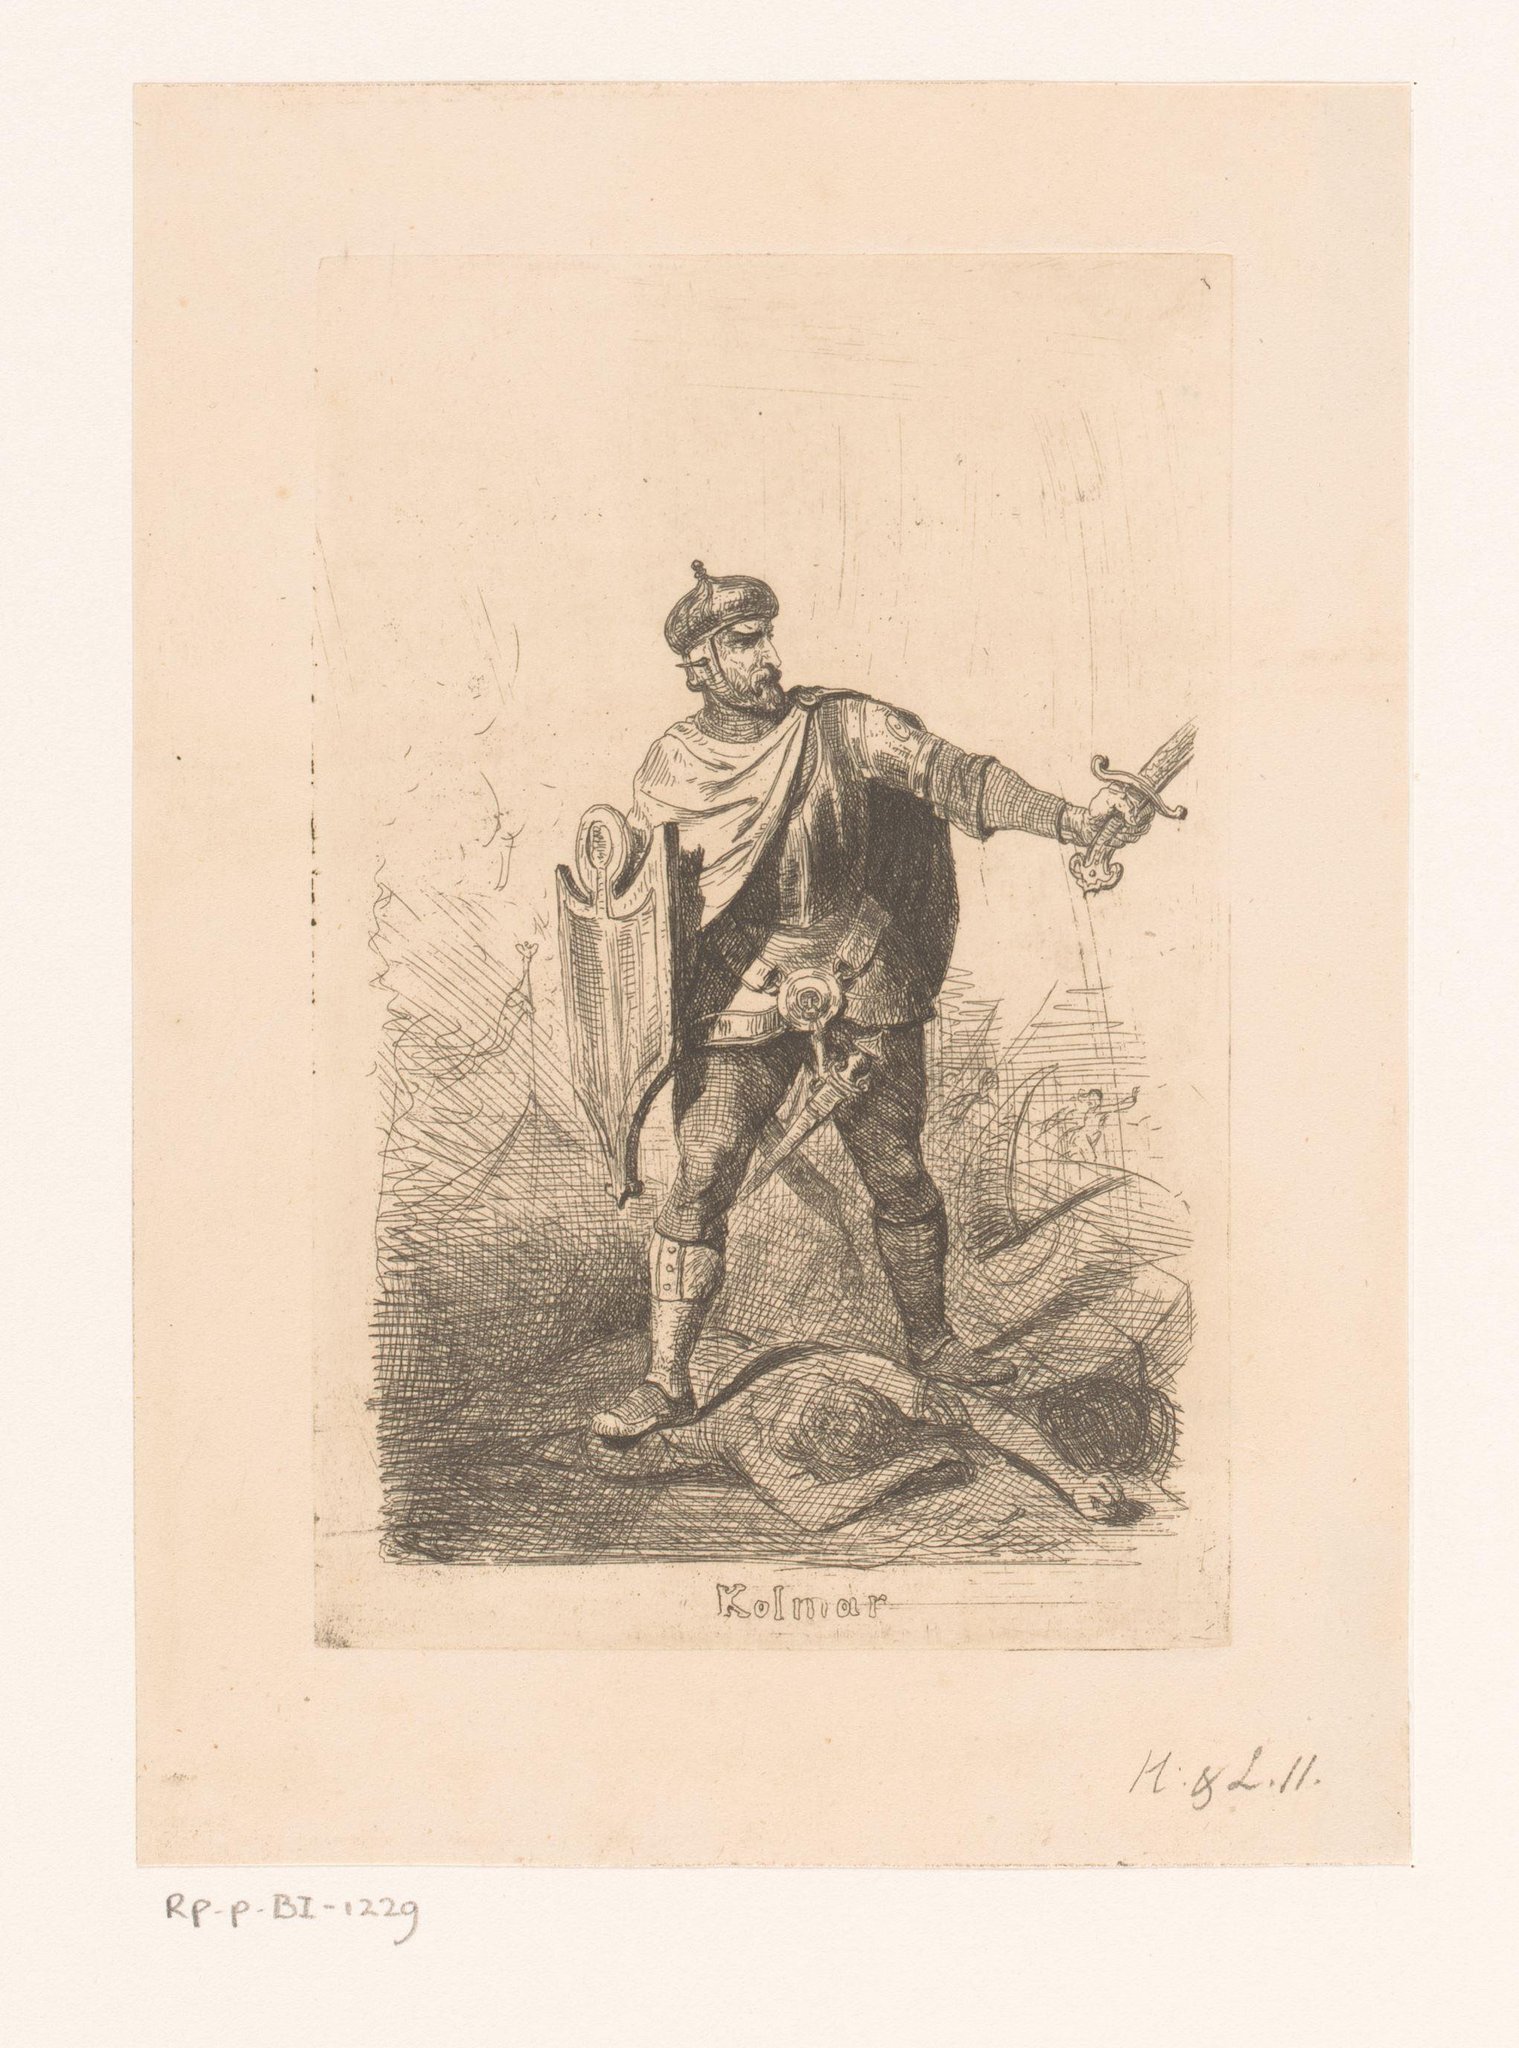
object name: print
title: Kolmar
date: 1842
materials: paper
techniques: etching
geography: antwerp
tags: armour, adult man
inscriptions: collector's mark: Lugt 2228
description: Prent uit: Kerckhoven, Pieter Frans van. Oud Belgiën: twee dichtkundige tafereelen uit de Oude geschiedenis des vaderlands. Antwerpen: P. van Bouwel, 1842.